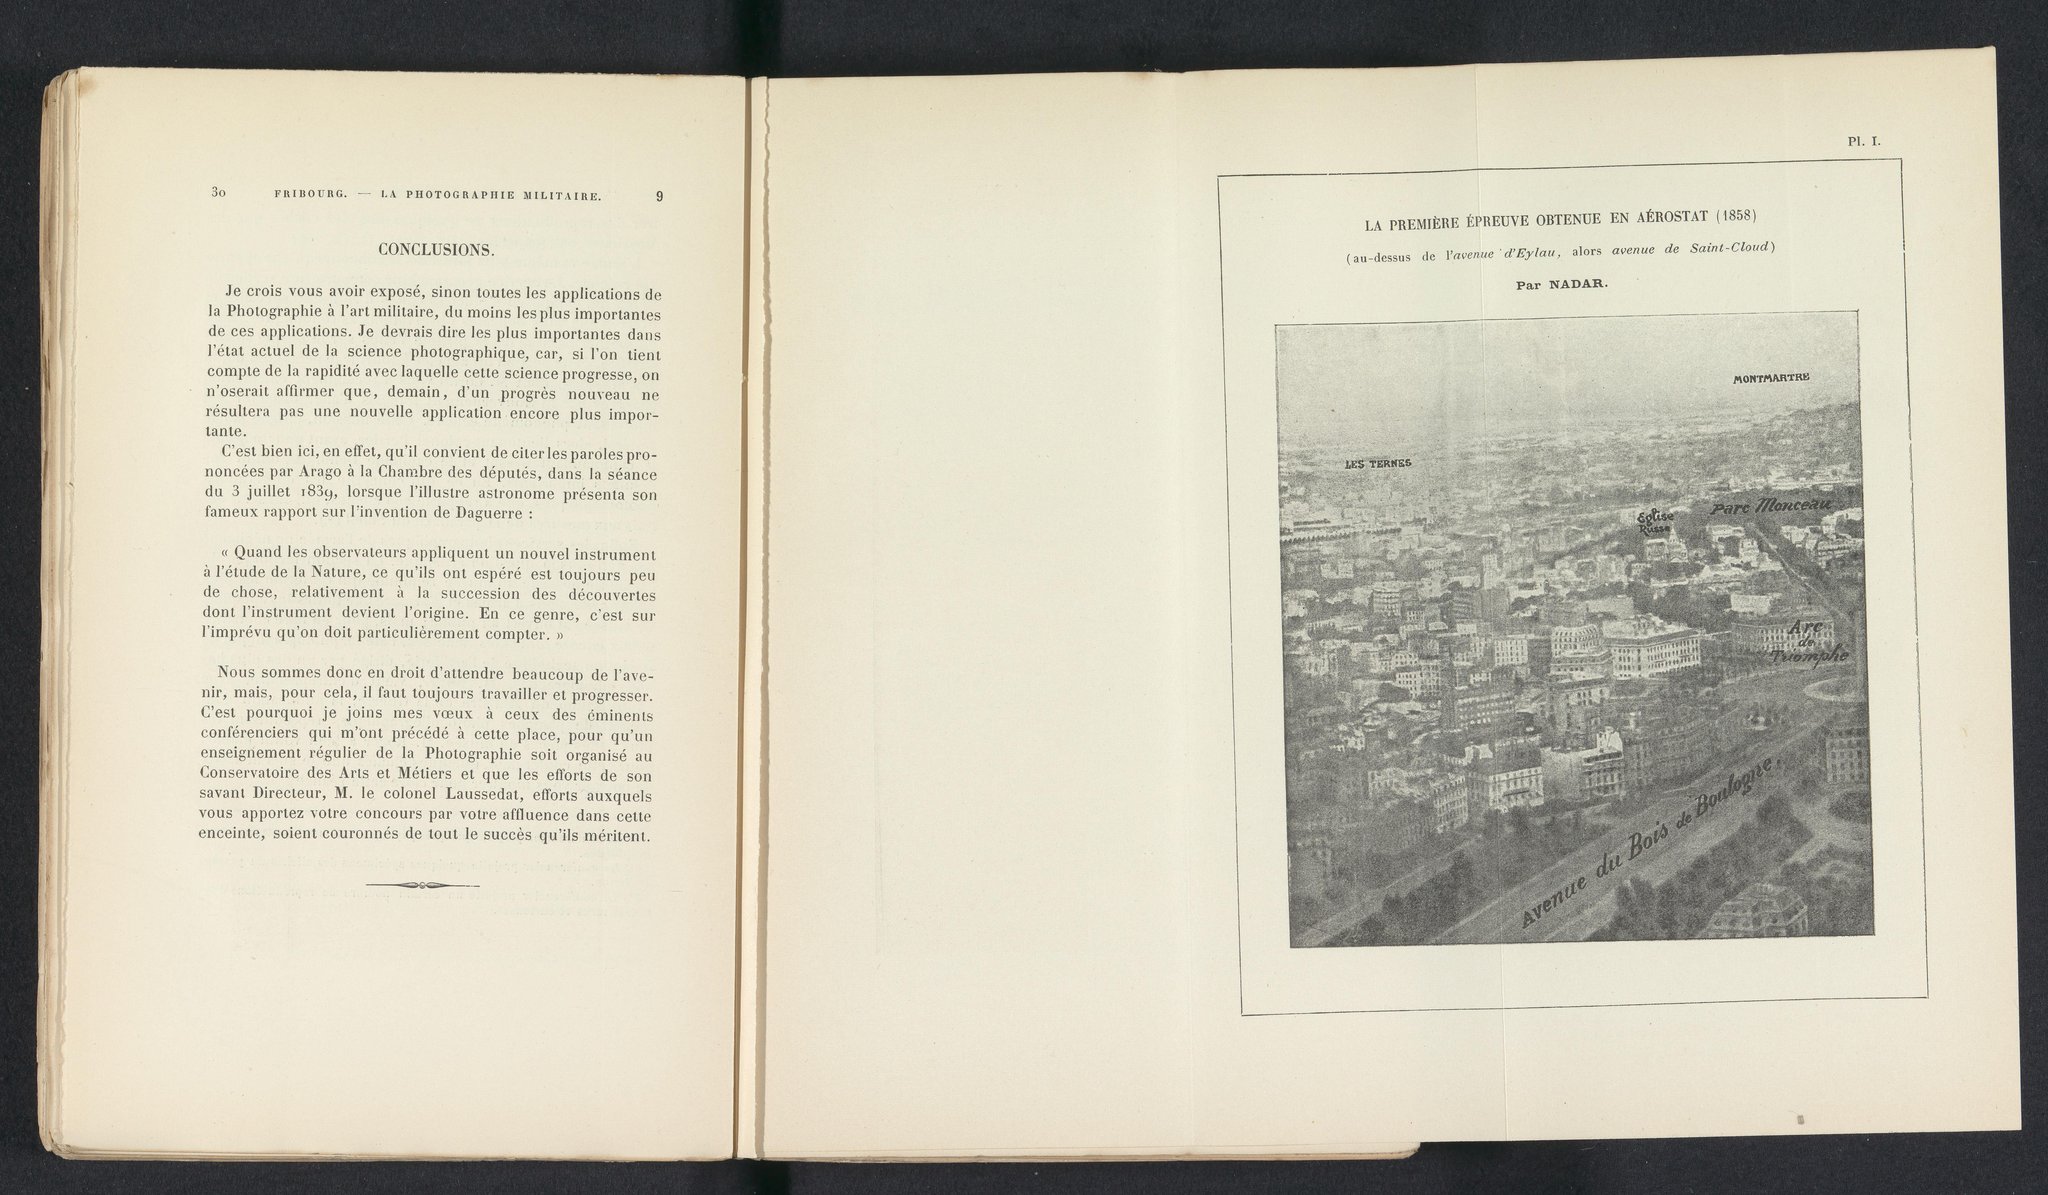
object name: page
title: Le première epreuve obtenue en aérostat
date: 1893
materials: paper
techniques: autotype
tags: city-view in general; 'veduta', paris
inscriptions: number: ‘Pl. I.’